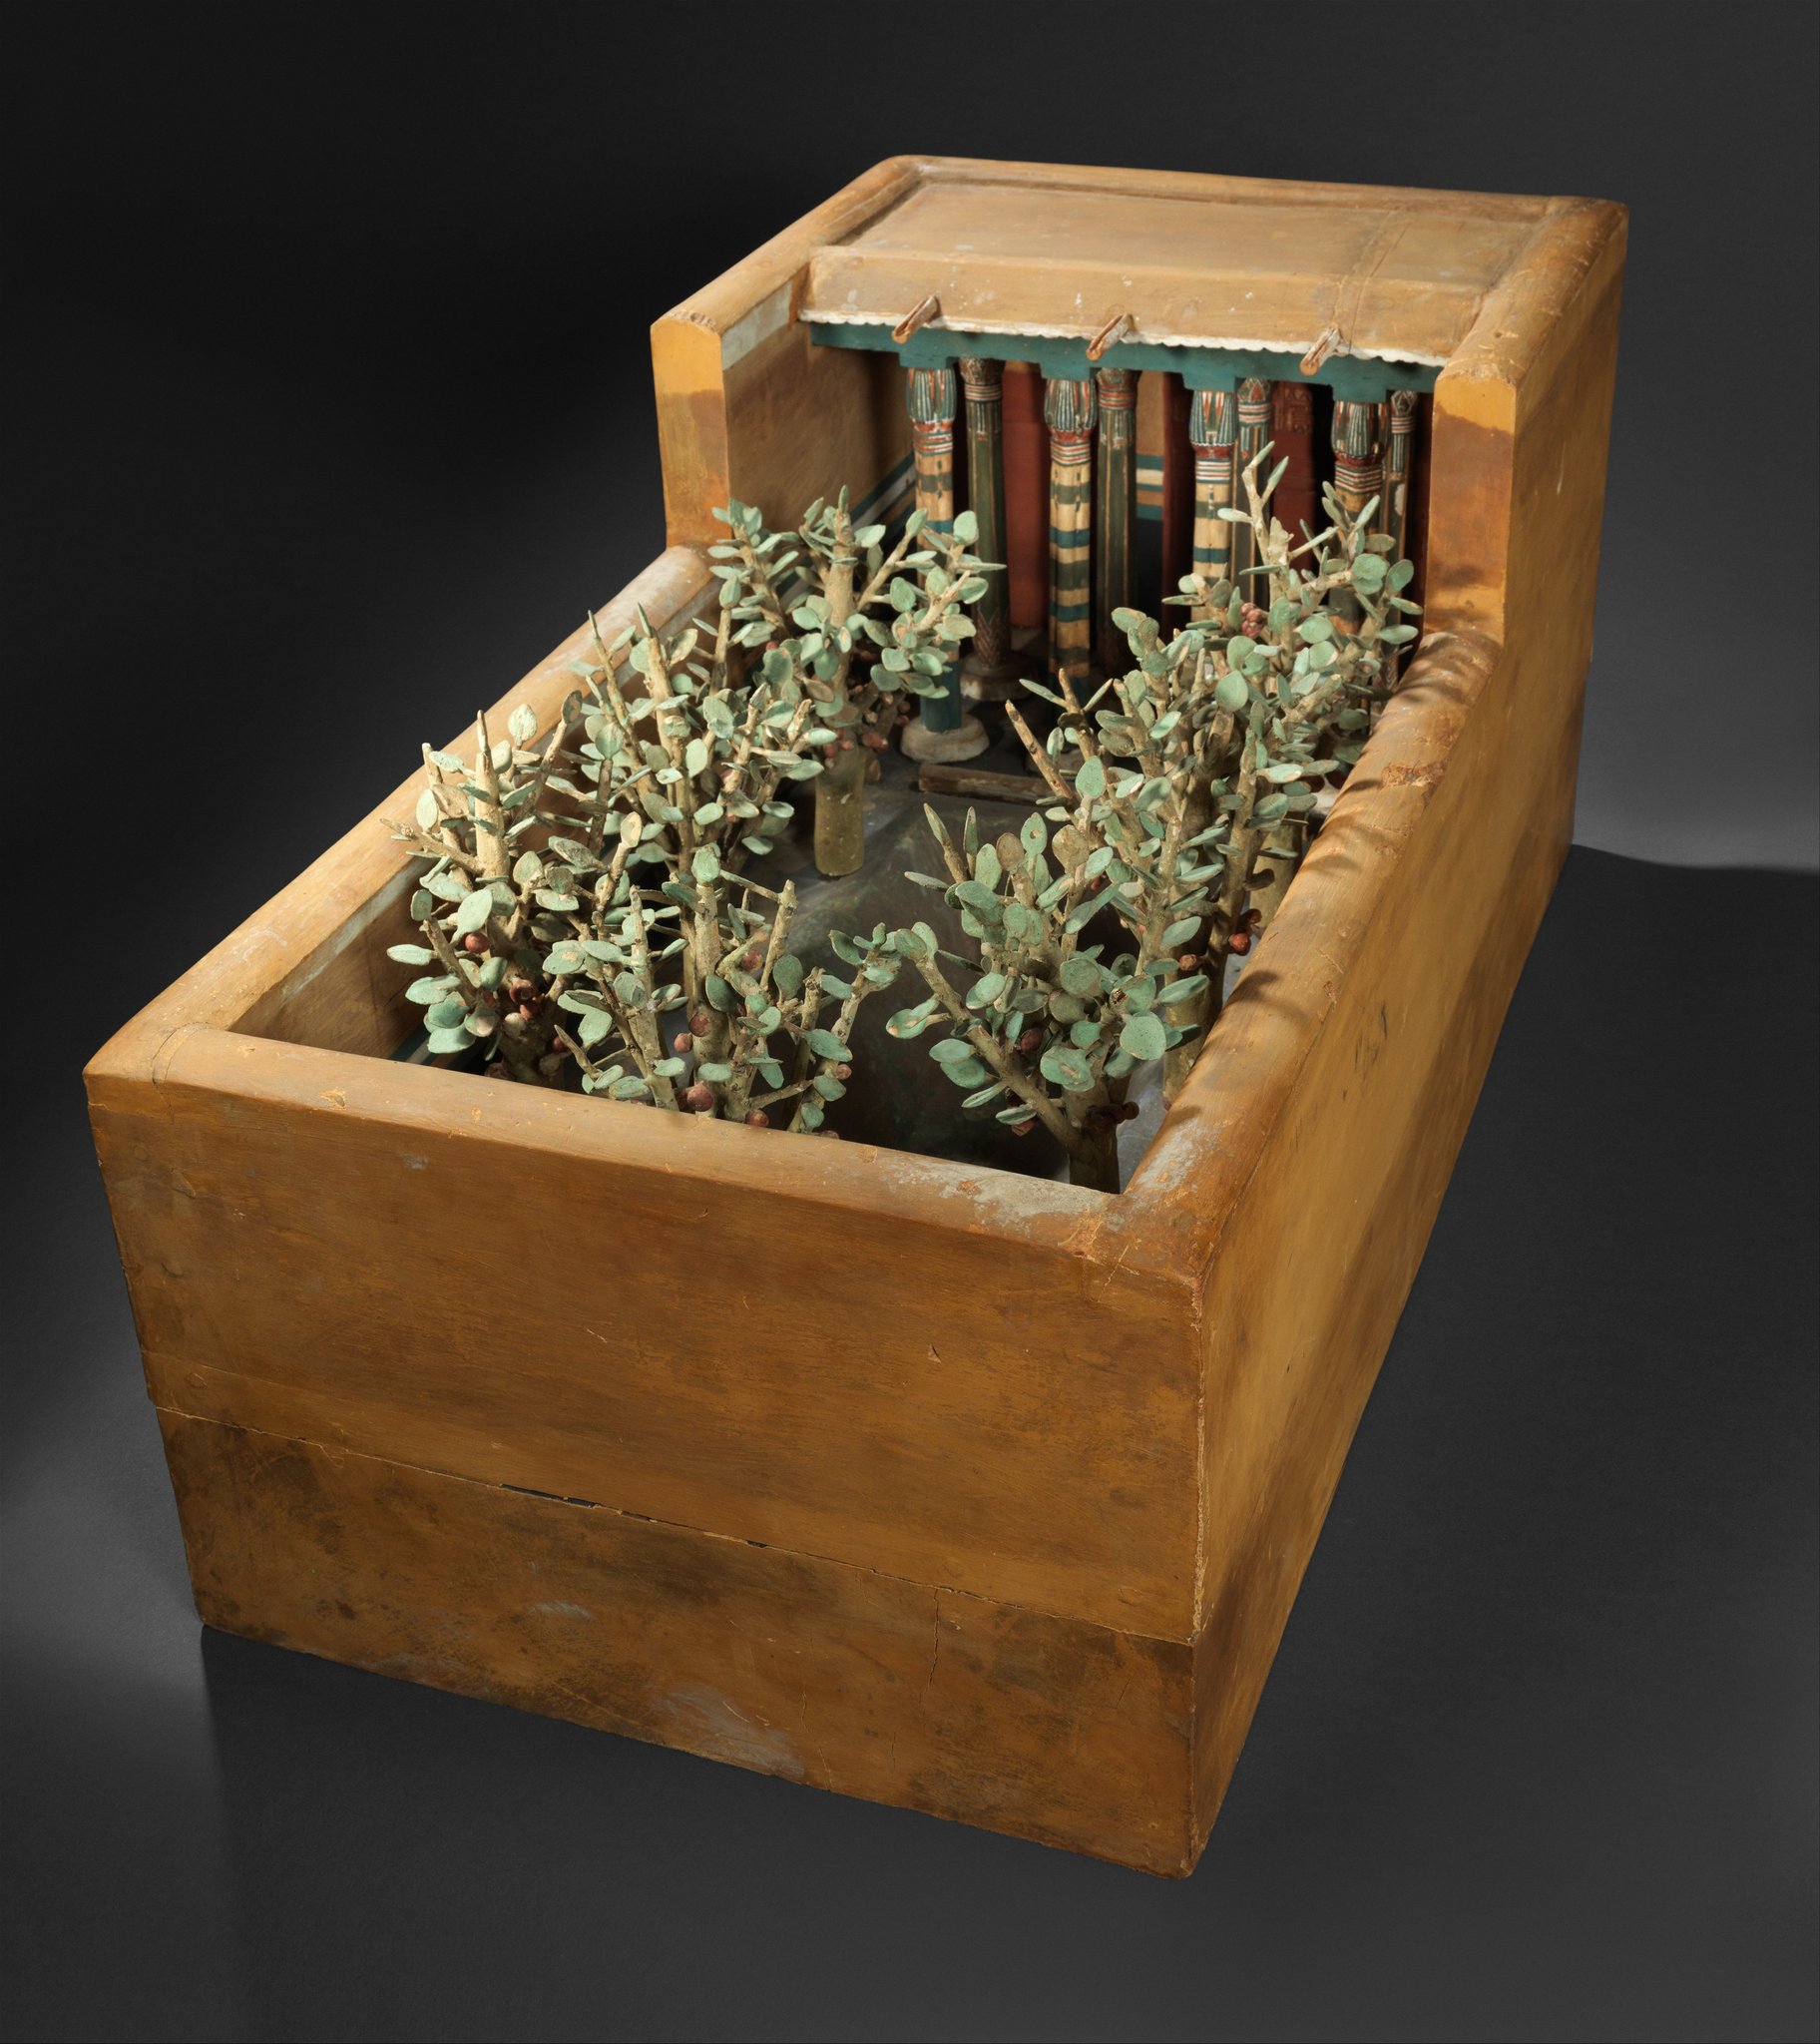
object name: model, garden, meketre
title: Model of a Porch and Garden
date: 1981-1975 BCE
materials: copper, paint, wood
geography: egypt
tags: gardens,meketre-models